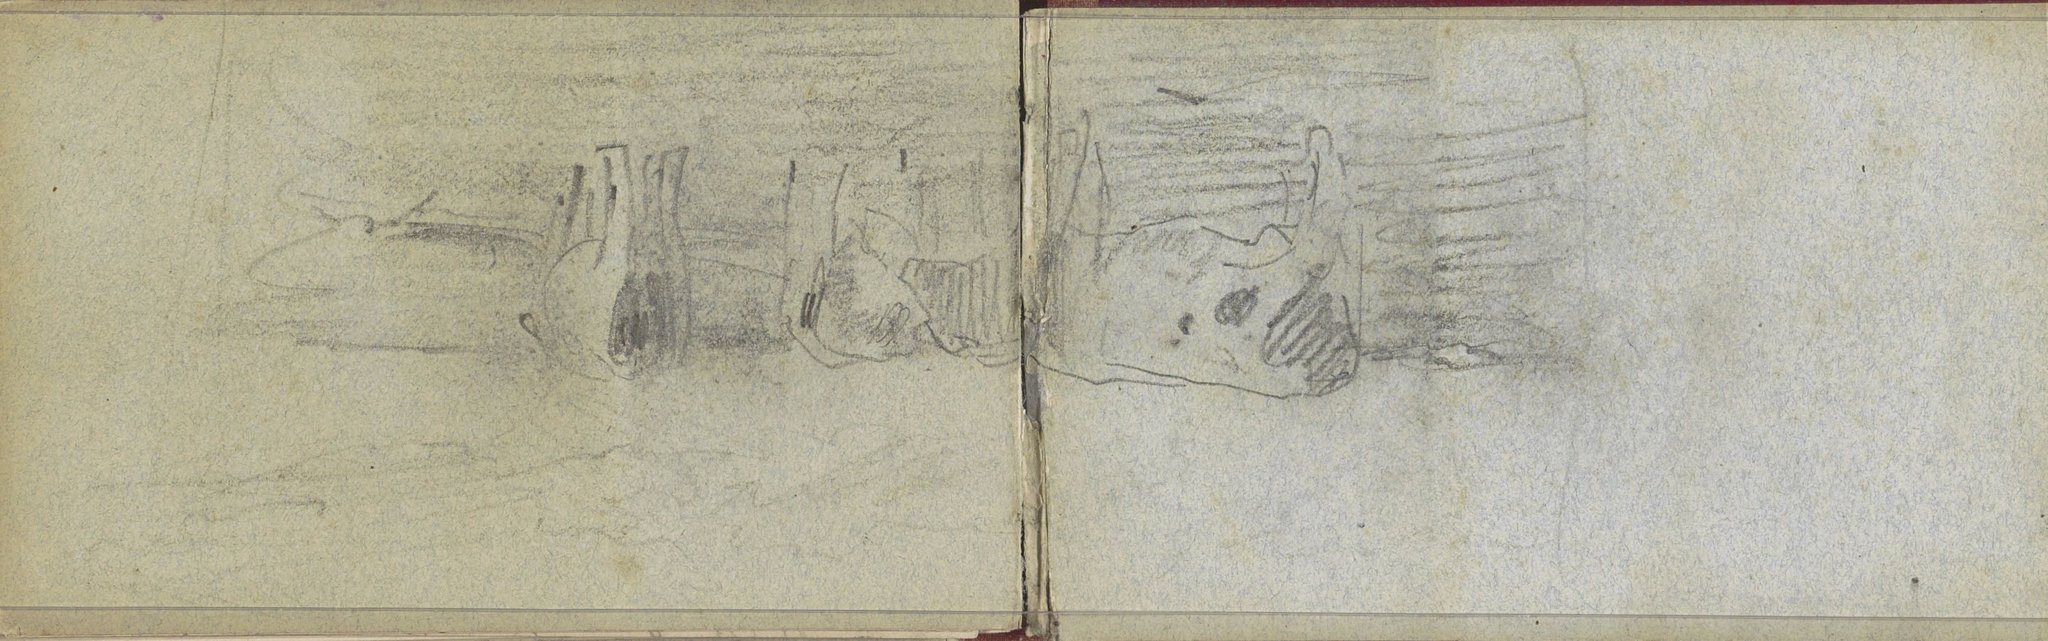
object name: sketchbook leaf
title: Koeien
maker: anton mauve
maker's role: draughtsman, painter, print maker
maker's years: 1838-1888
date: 1876-1888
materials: paper, pencil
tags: cow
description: Blad 34 verso uit en het achterste schutblad van een schetsboek met 34 bladen.